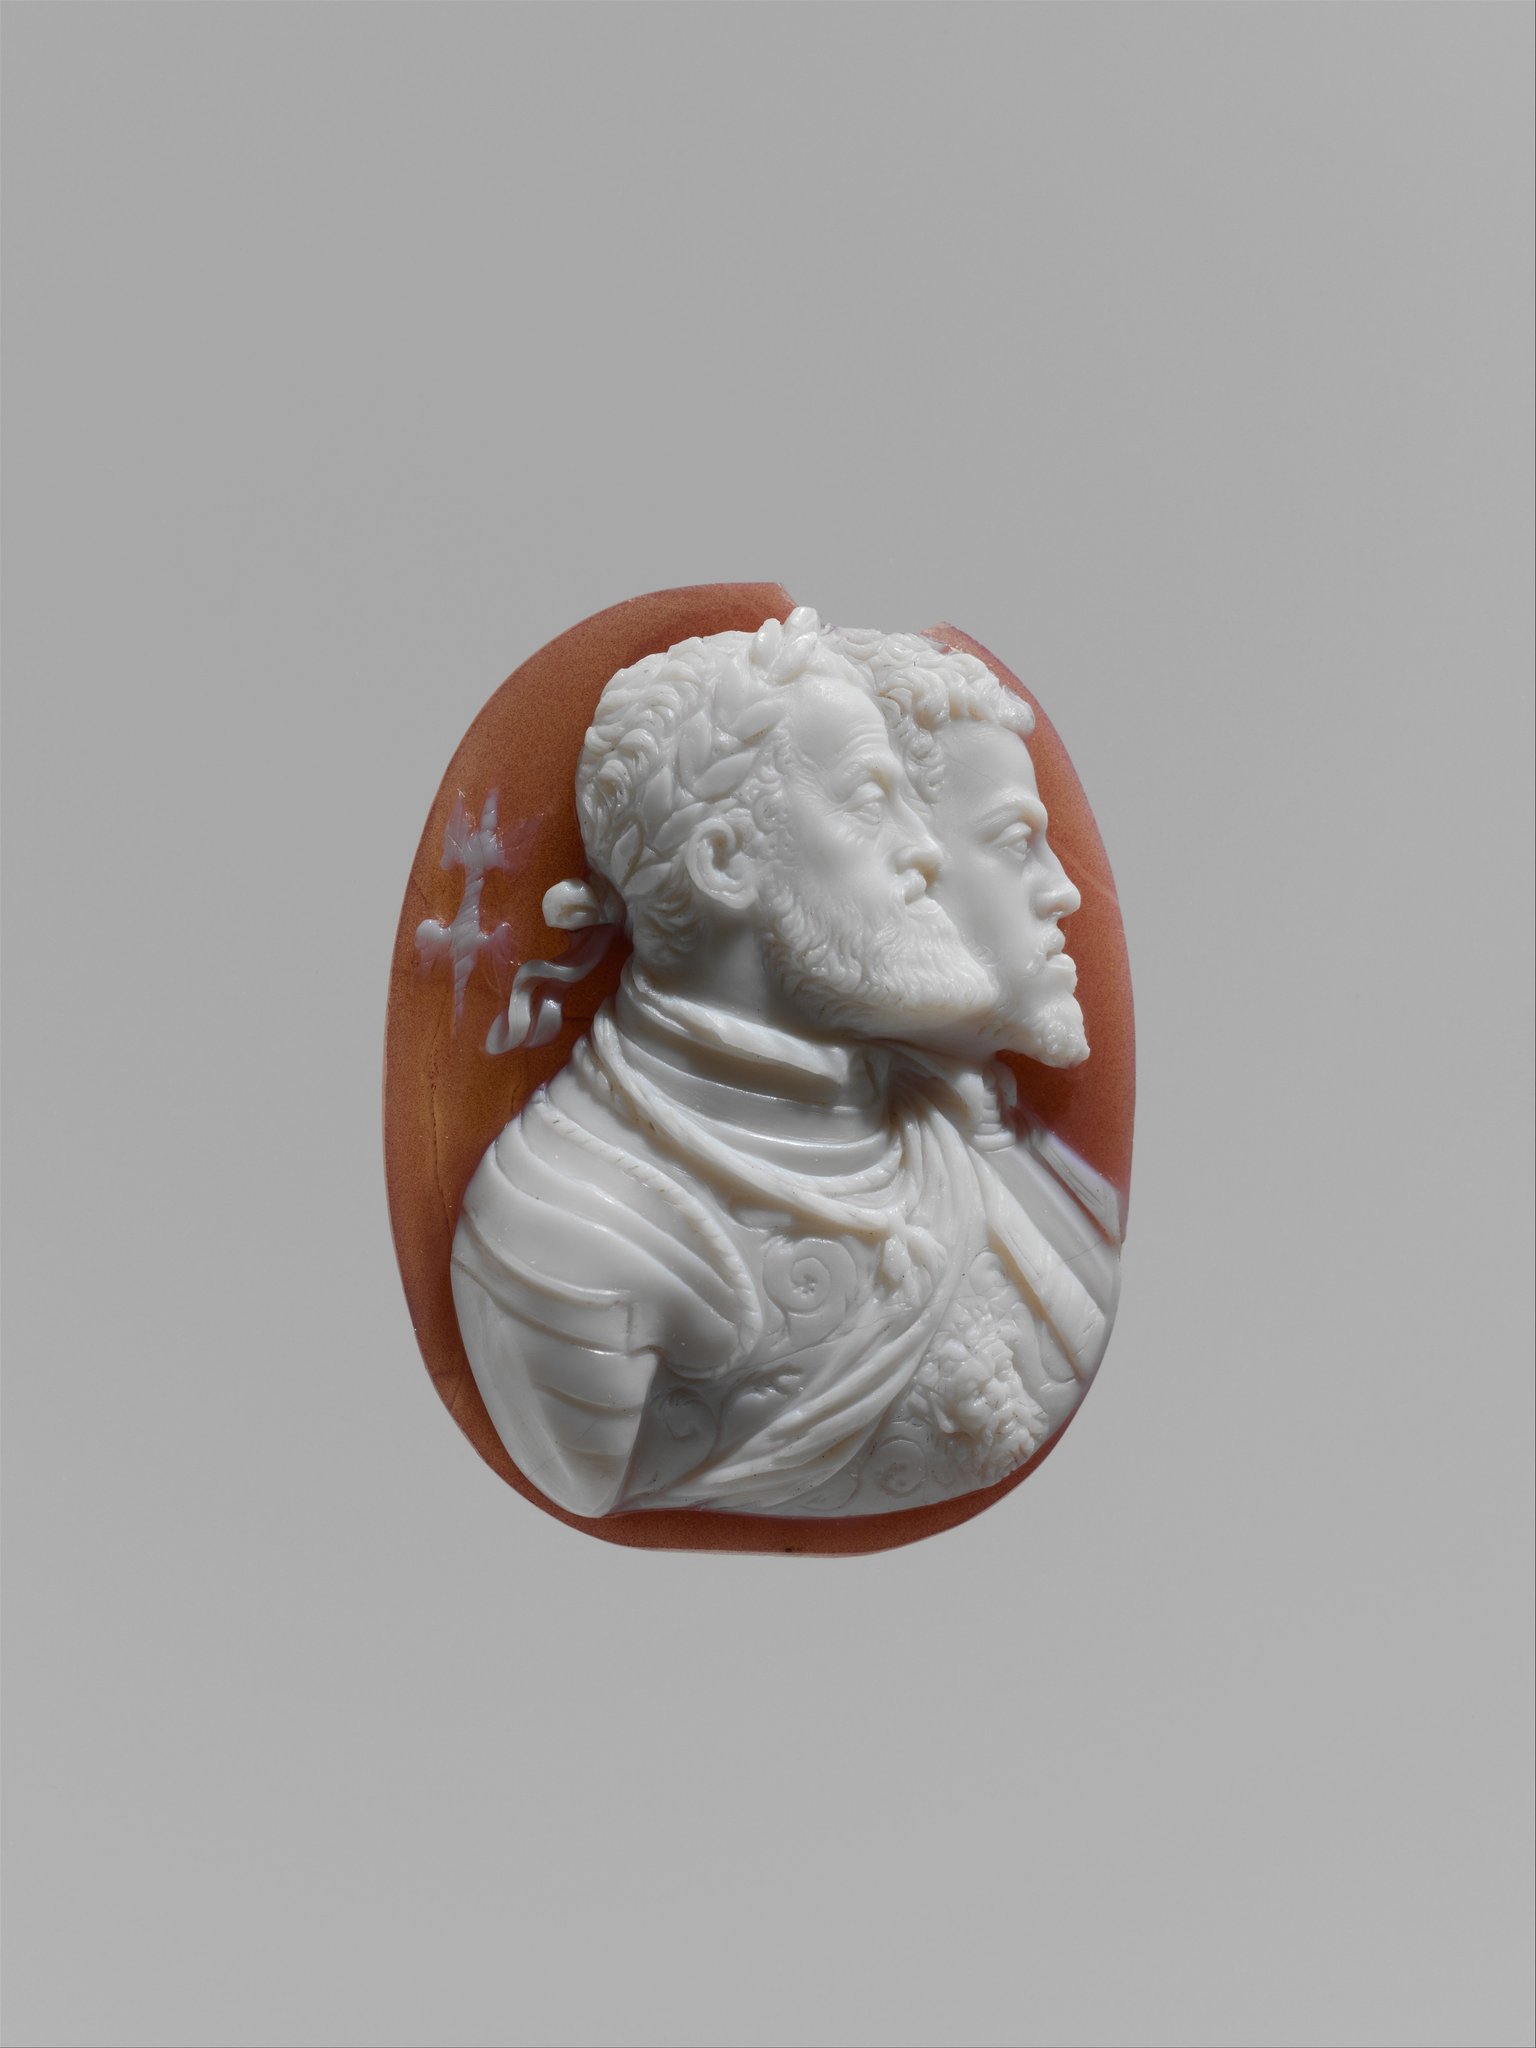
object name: cameo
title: Emperor Charles V (1500–1558) and his Son Philip II of Spain (1527–1598)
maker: leone leoni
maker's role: artist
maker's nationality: italian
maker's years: 1504-1590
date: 1550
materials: gemstone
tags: men,profiles